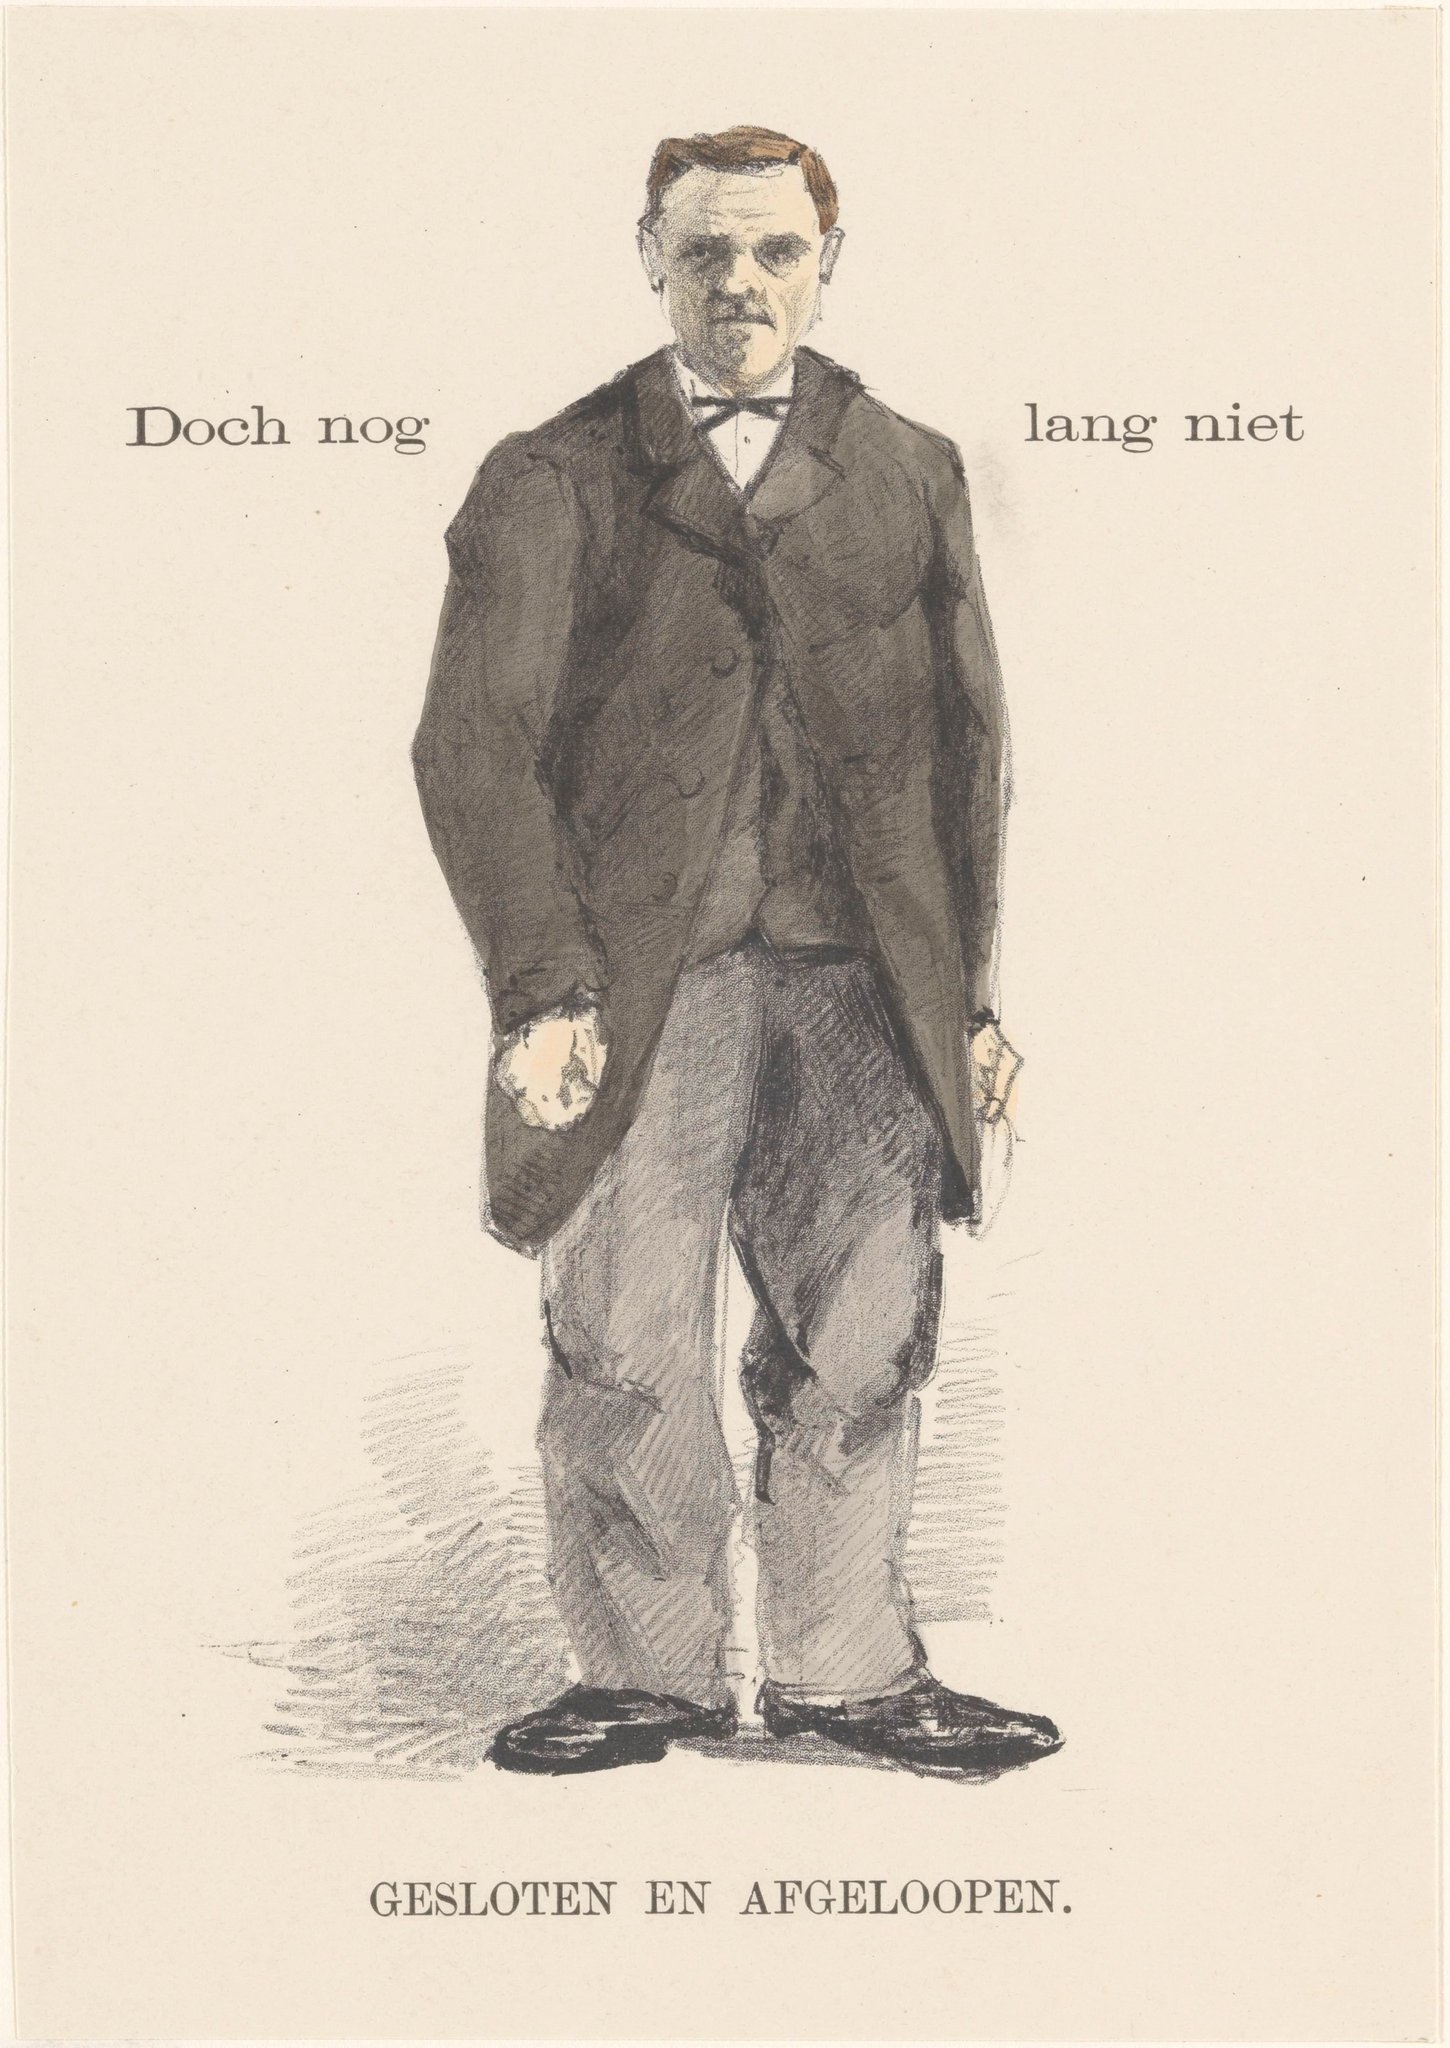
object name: print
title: Staande man in overjas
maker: theo van hoytema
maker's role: draughtsman, painter, print maker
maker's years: 1863-1917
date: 1878-1917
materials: paper, watercolor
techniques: hand coloring, letterpress printing, lithograph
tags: standing figure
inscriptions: collector's mark: Lugt 2228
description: Staande man met de tekst 'Doch nog lang niet gesloten en afgeloopen'.